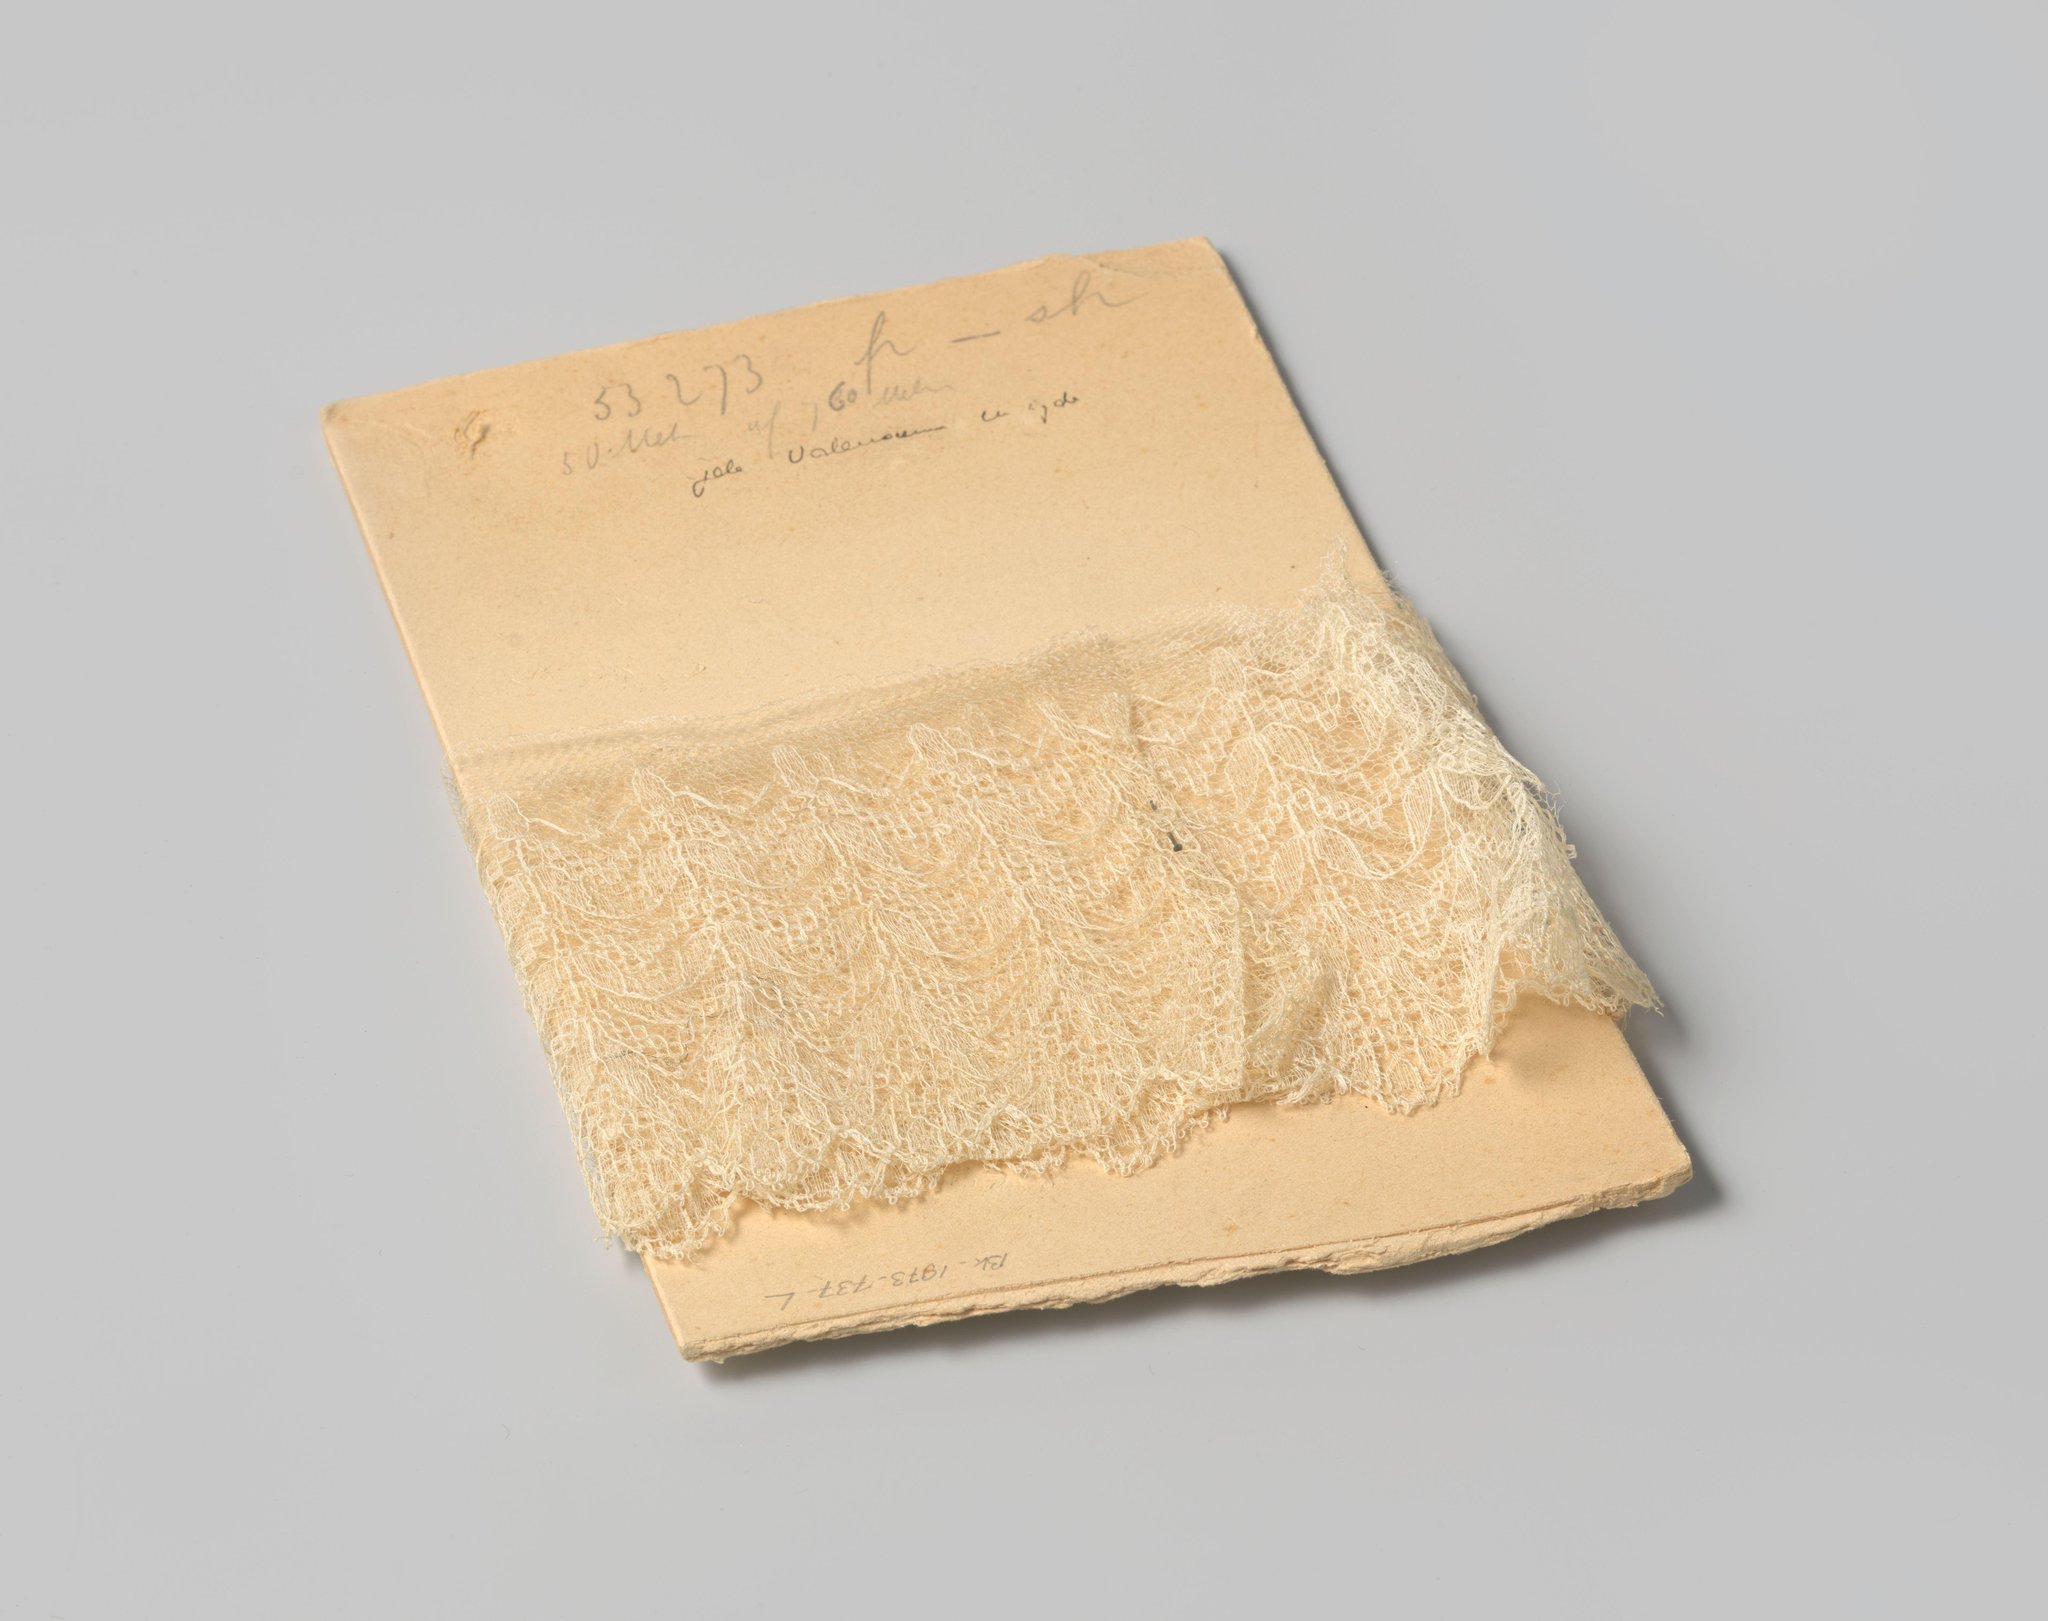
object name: strip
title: Strook witte kant met slingermotief op karton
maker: gustav schnitzler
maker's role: paraplufabrikant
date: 1925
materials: cardboard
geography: nijmegen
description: Metrages kant en passement, in wit en zwart en andere kleuren. Karton met witte geschulpte kant.